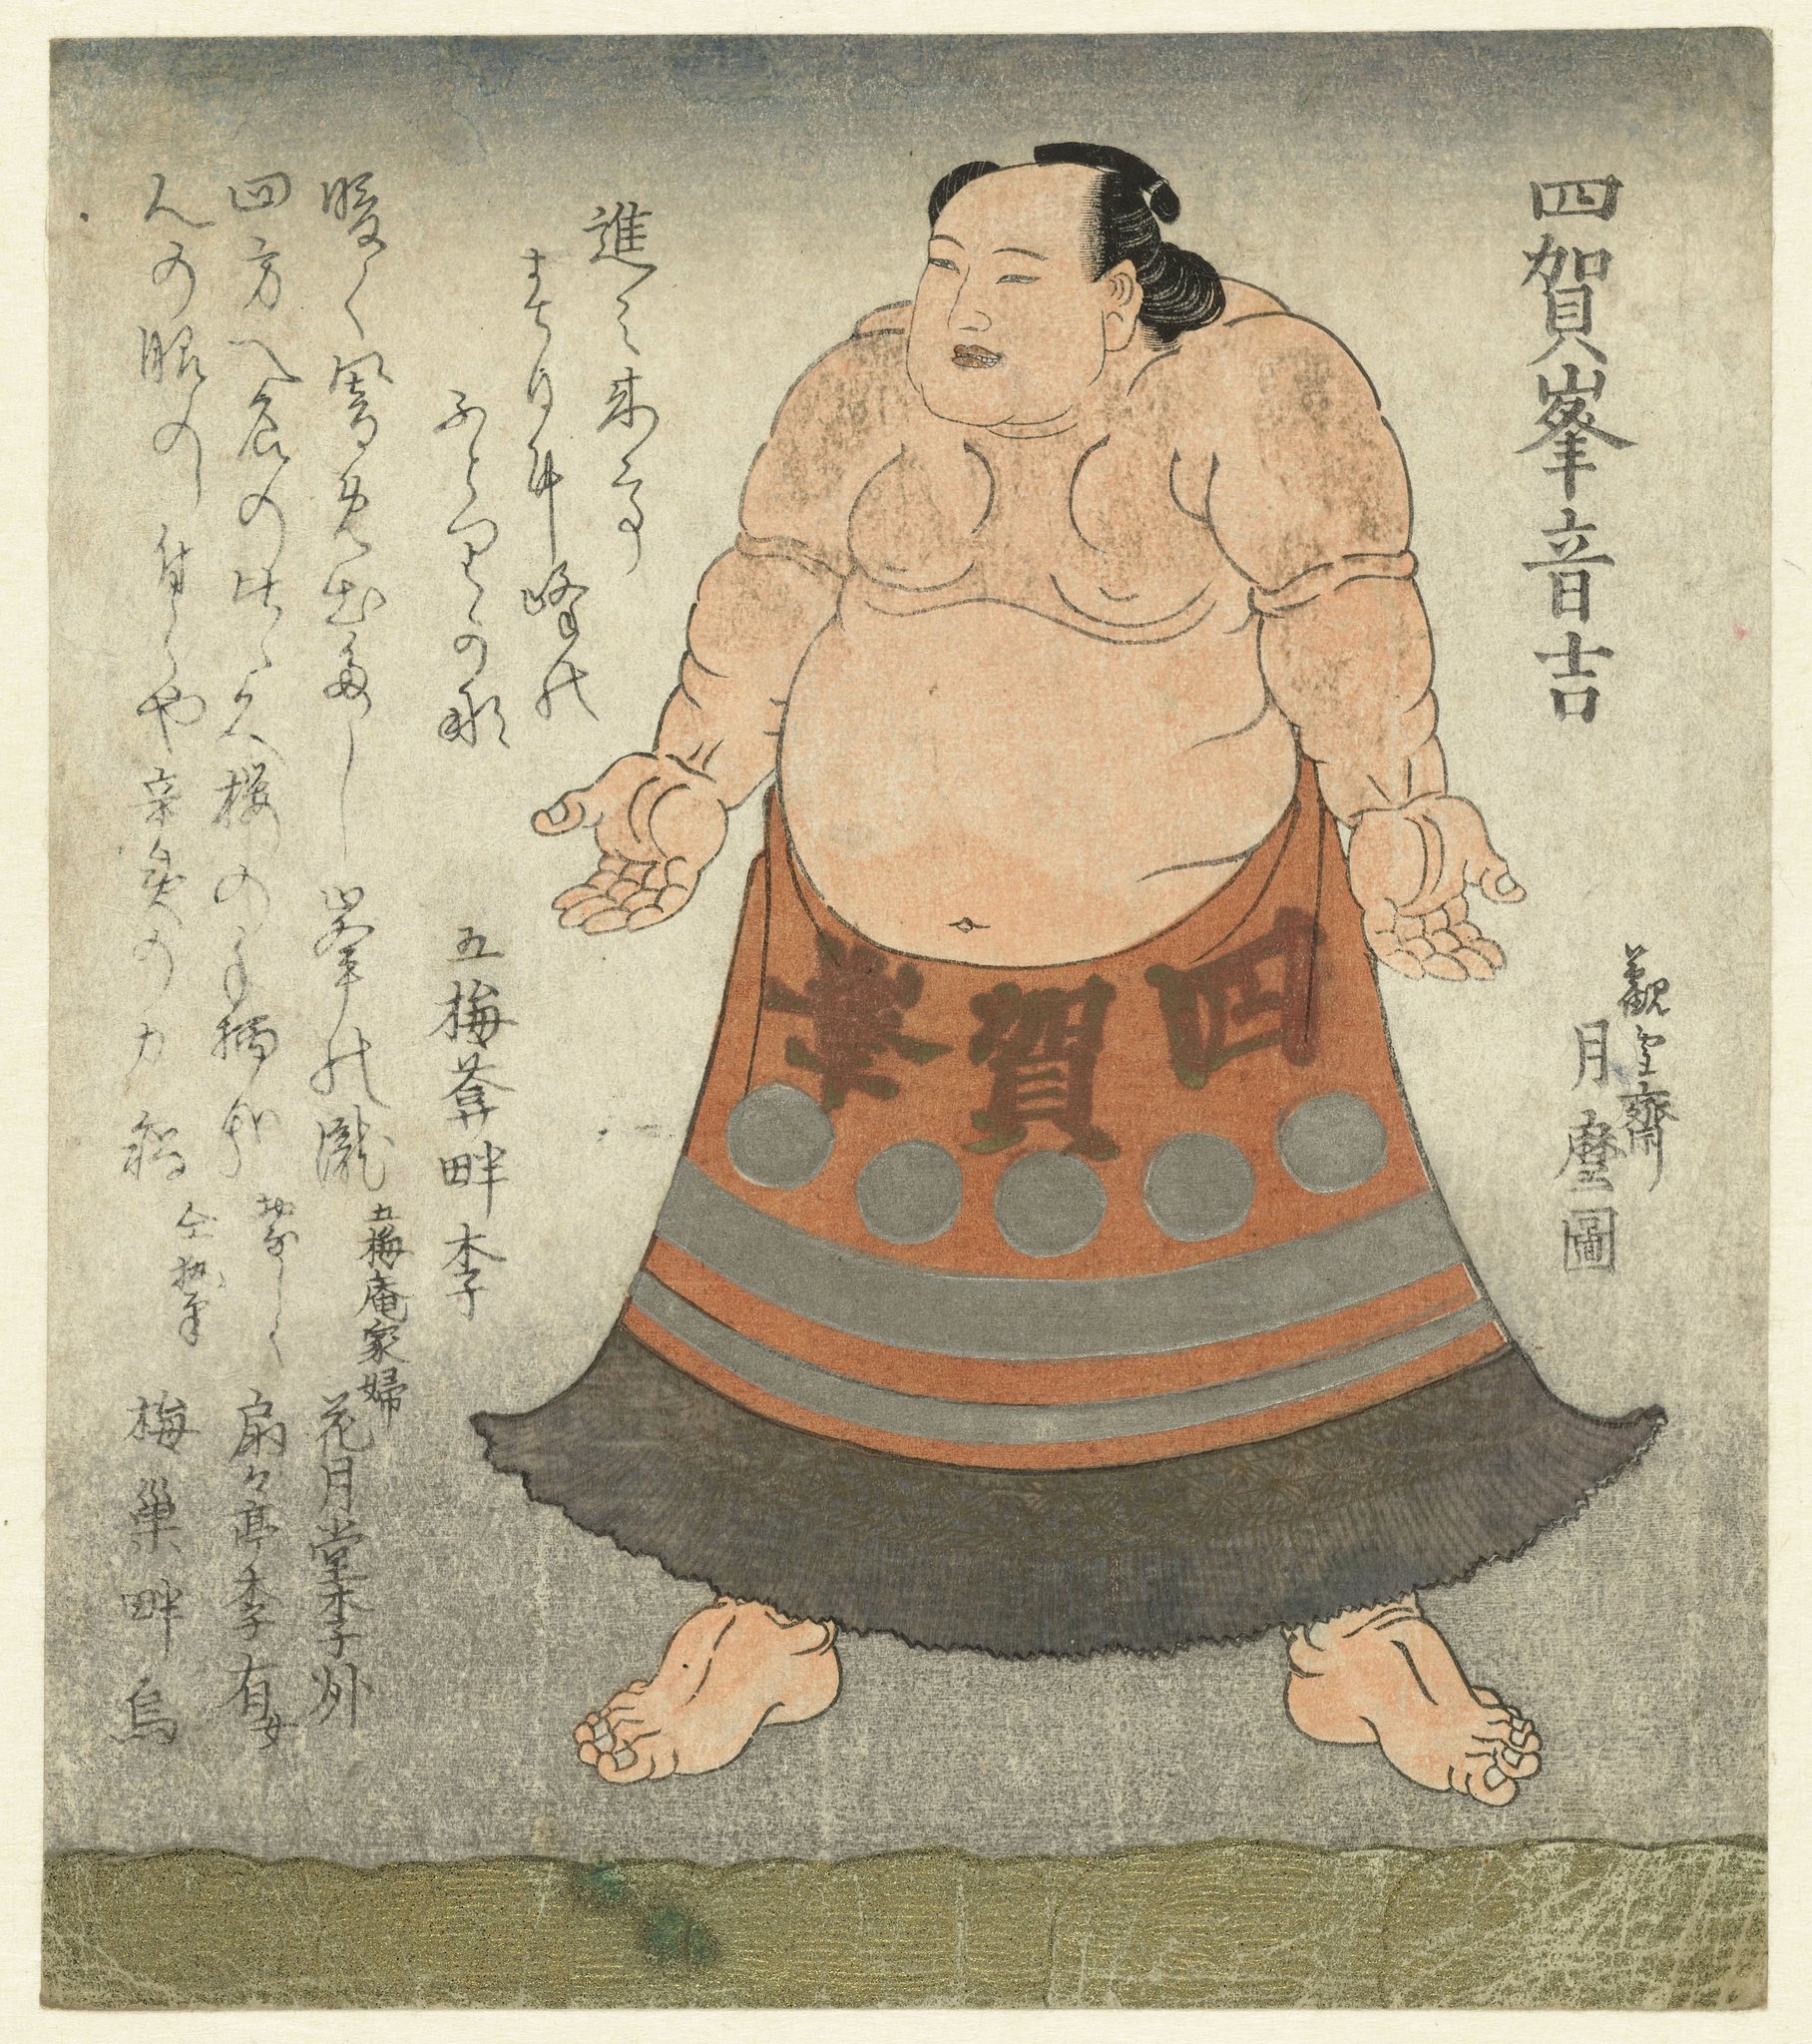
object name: print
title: A Sumo Wrestler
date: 1819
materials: paper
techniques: woodcut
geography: japan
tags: wrestling (sport) (+ sportsman, player, etc.)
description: Een surimono is een luxe uitgevoerde prent waarop beeld met één of meerdere gedichten gecombineerd is. Bij het drukken van een surimono werd vaak gebruik gemaakt van dikker papier, blinddruk en metaal pigmenten, zoals koper- en zilverpoeder. De prenten werden vaak in opdracht van dichters gemaakt en als exclusief geschenk aan vrienden en relaties gegeven.